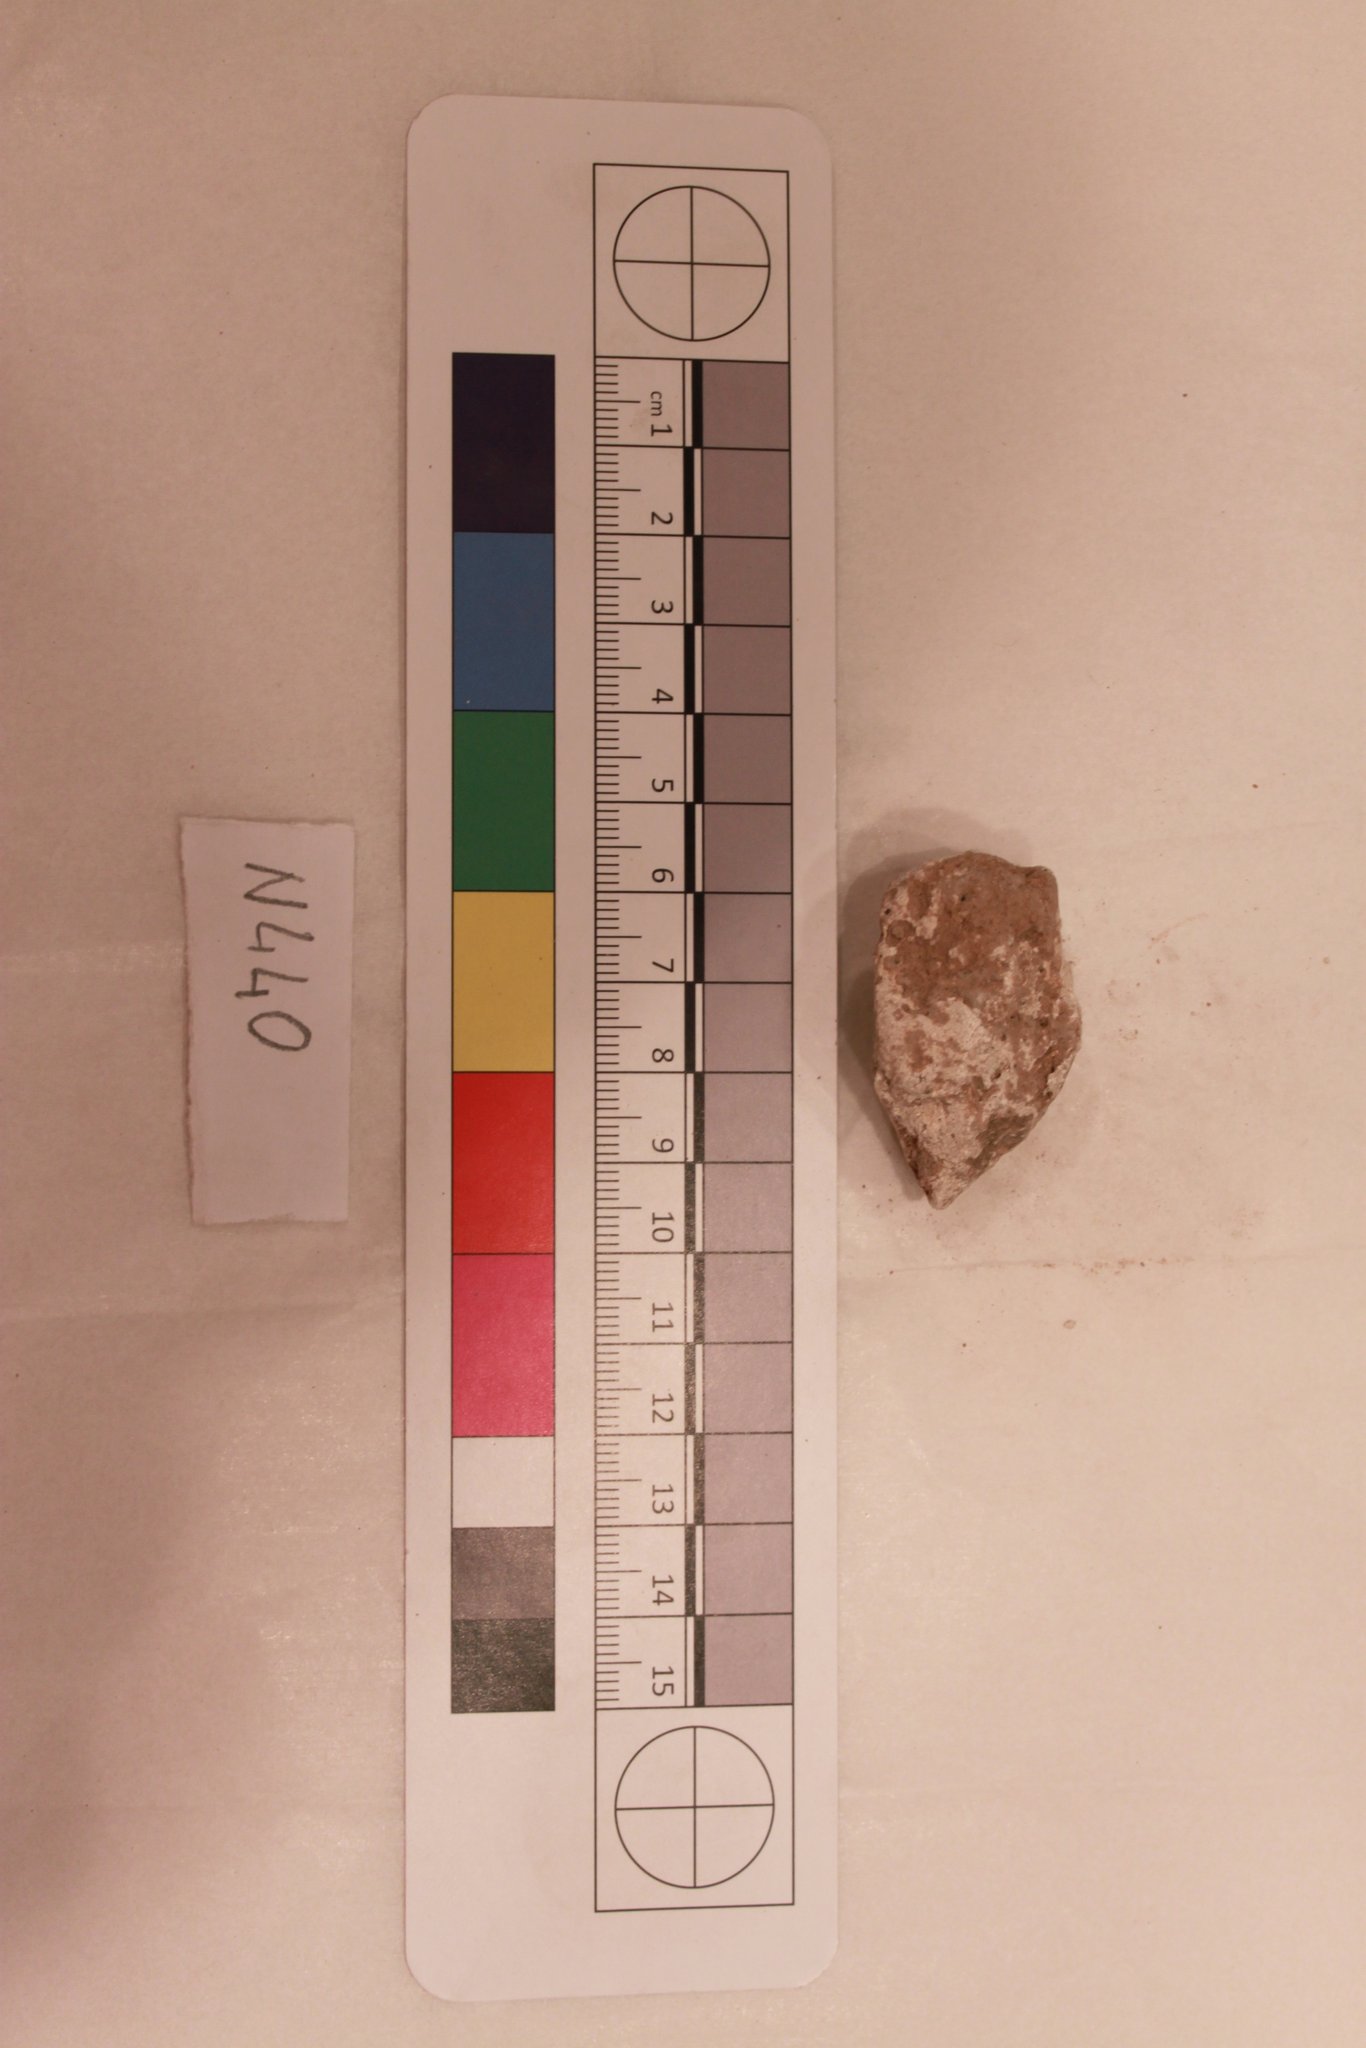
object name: fragment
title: Stucco Fragment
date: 701-1200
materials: plaster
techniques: carving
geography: iran